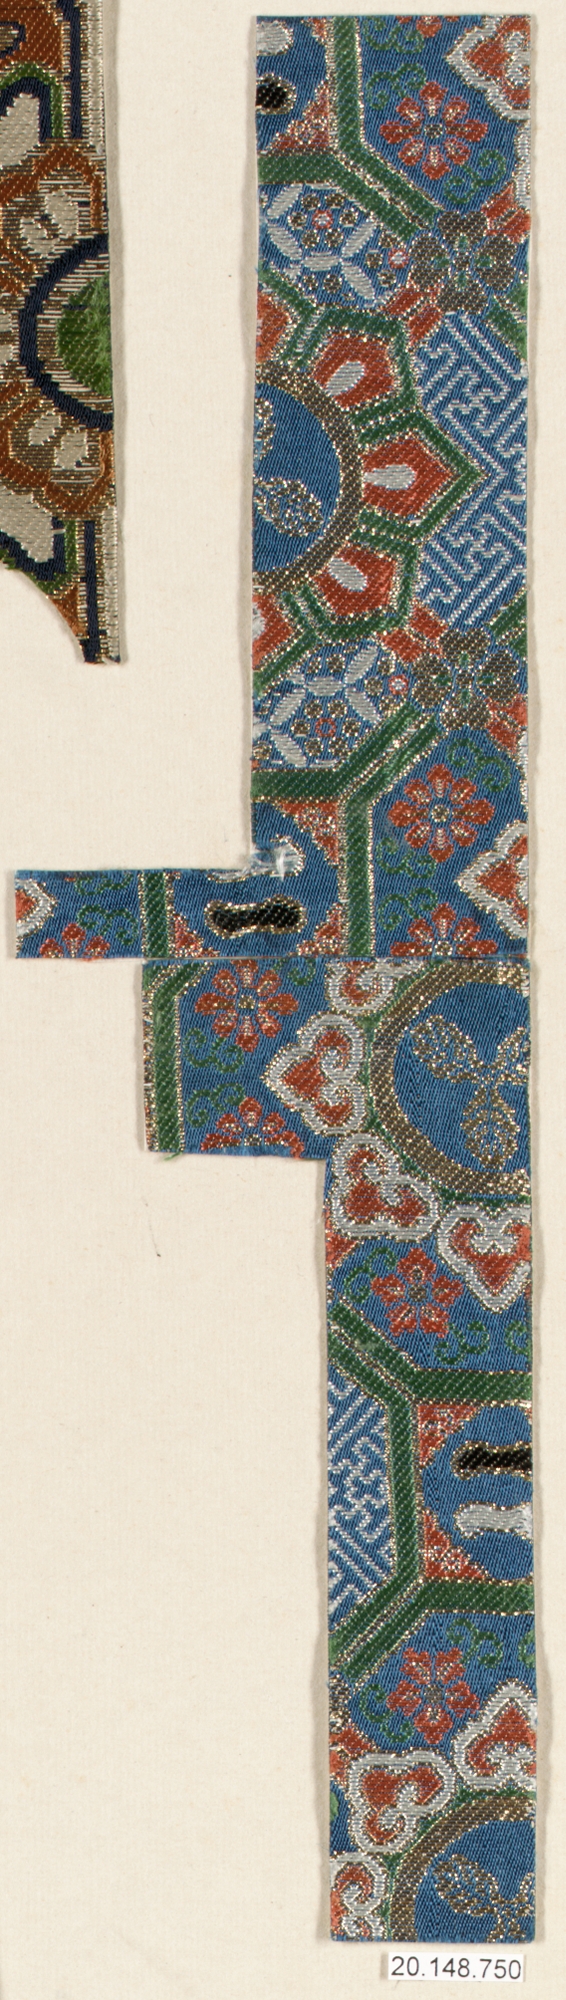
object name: brocade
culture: china or japan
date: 1601-1700